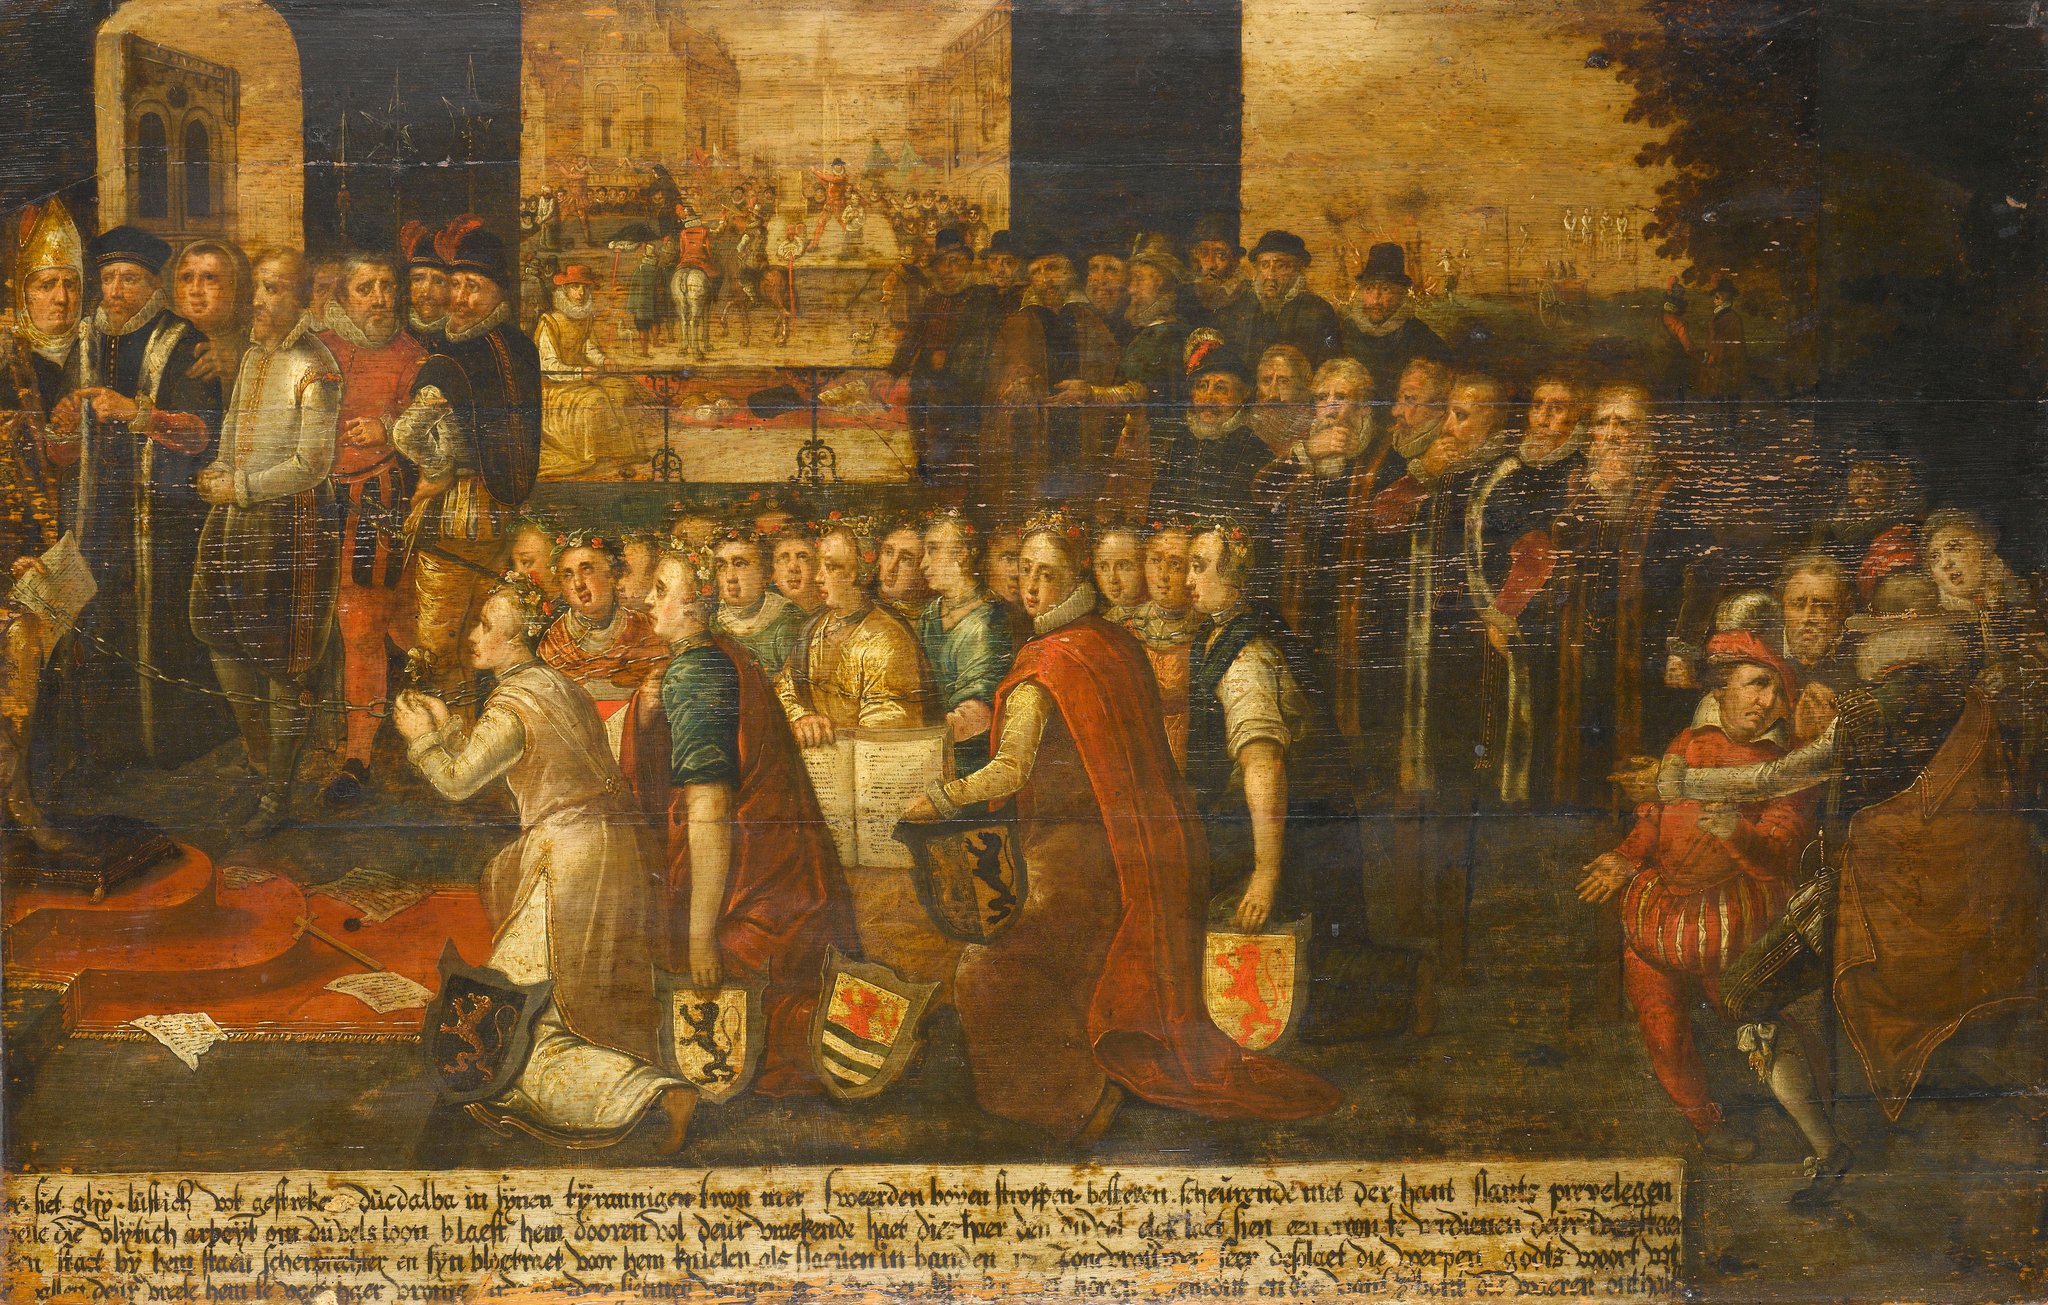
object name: painting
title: Allegory of the Tyranny of the Duke of Alba in the Netherlands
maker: Anonymous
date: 1622-1630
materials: oil, panel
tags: fernando álvarez de toledo (3rd duke of alba), tyrant, dictator, historical persons, low countries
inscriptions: coat of arms, second from left: a black lion rampant on a silver field (unidentified province), coat of arms, second from right: divided vertically, 1, a gold lion rampant reversed on a blue field; 2, a black lion rampant on a gold field (province of Gelderland), inscription, bottom: ‘[..]er. siet. ghij. lustich wt gestreke[.] ducdalba in sijnen tijrannigen troon met sweerden boijen stroppen. bes[..]eren. scheurende met der hant slants prevelegen / [...]elle die vlijtich arbeijt om duvelsloon blaest hem d' ooren vol deur wr[?]ekende haet die haer den duvel elck laet sien een croon te verdienen deur 't v[..]staen / [..]sta[.]t bij hem staen scherprechter en sijn bloetraet voor hem knielen als slaeven in banden 17 Joncvrouwe. seer desolaet die werpen godts woort wt / [...] allen deur vreese hem te voe[.] haer vrome [......] dere sietmen [......] en die vant verbont die waeren onthalst / [......]’, coat of arms, centre: divided horizontally, A, a red demi-lion rising up on a gold field; B, two silver bars on a blue field (province of Zeeland), coat of arms, left: a gold lion rampant on a black field (province of North Brabant), coat of arms, right: a red lion rampant on a gold field (province of South Holland)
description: Fragment van een allegorie op de tirannie van de hertog van Alva in de Nederlanden. Het deel van de voorstelling uiterst links met de hertog van Alva zittend op zijn troon ontbreekt. In het midden de zeventien Nederlandse provincies met provinciewapens geknield en geboeid in gevangenschap. Links de leden van Alva's Bloedraad, rechts de met stomheid geslagen leden van de Staten-Generaal. Rechts op de voorgrond een groep toeschouwers. Op de achtergrond links de onthoofding van de graven van Egmont en Hoorne te Brussel, mei 1568, en de hertogin van Parma vissend in een vijver. Rechts op de achtergrond martelingen, brandstapels en lijken aan galgen. Gebaseerd op een prent van Willem Delff uit 1622.